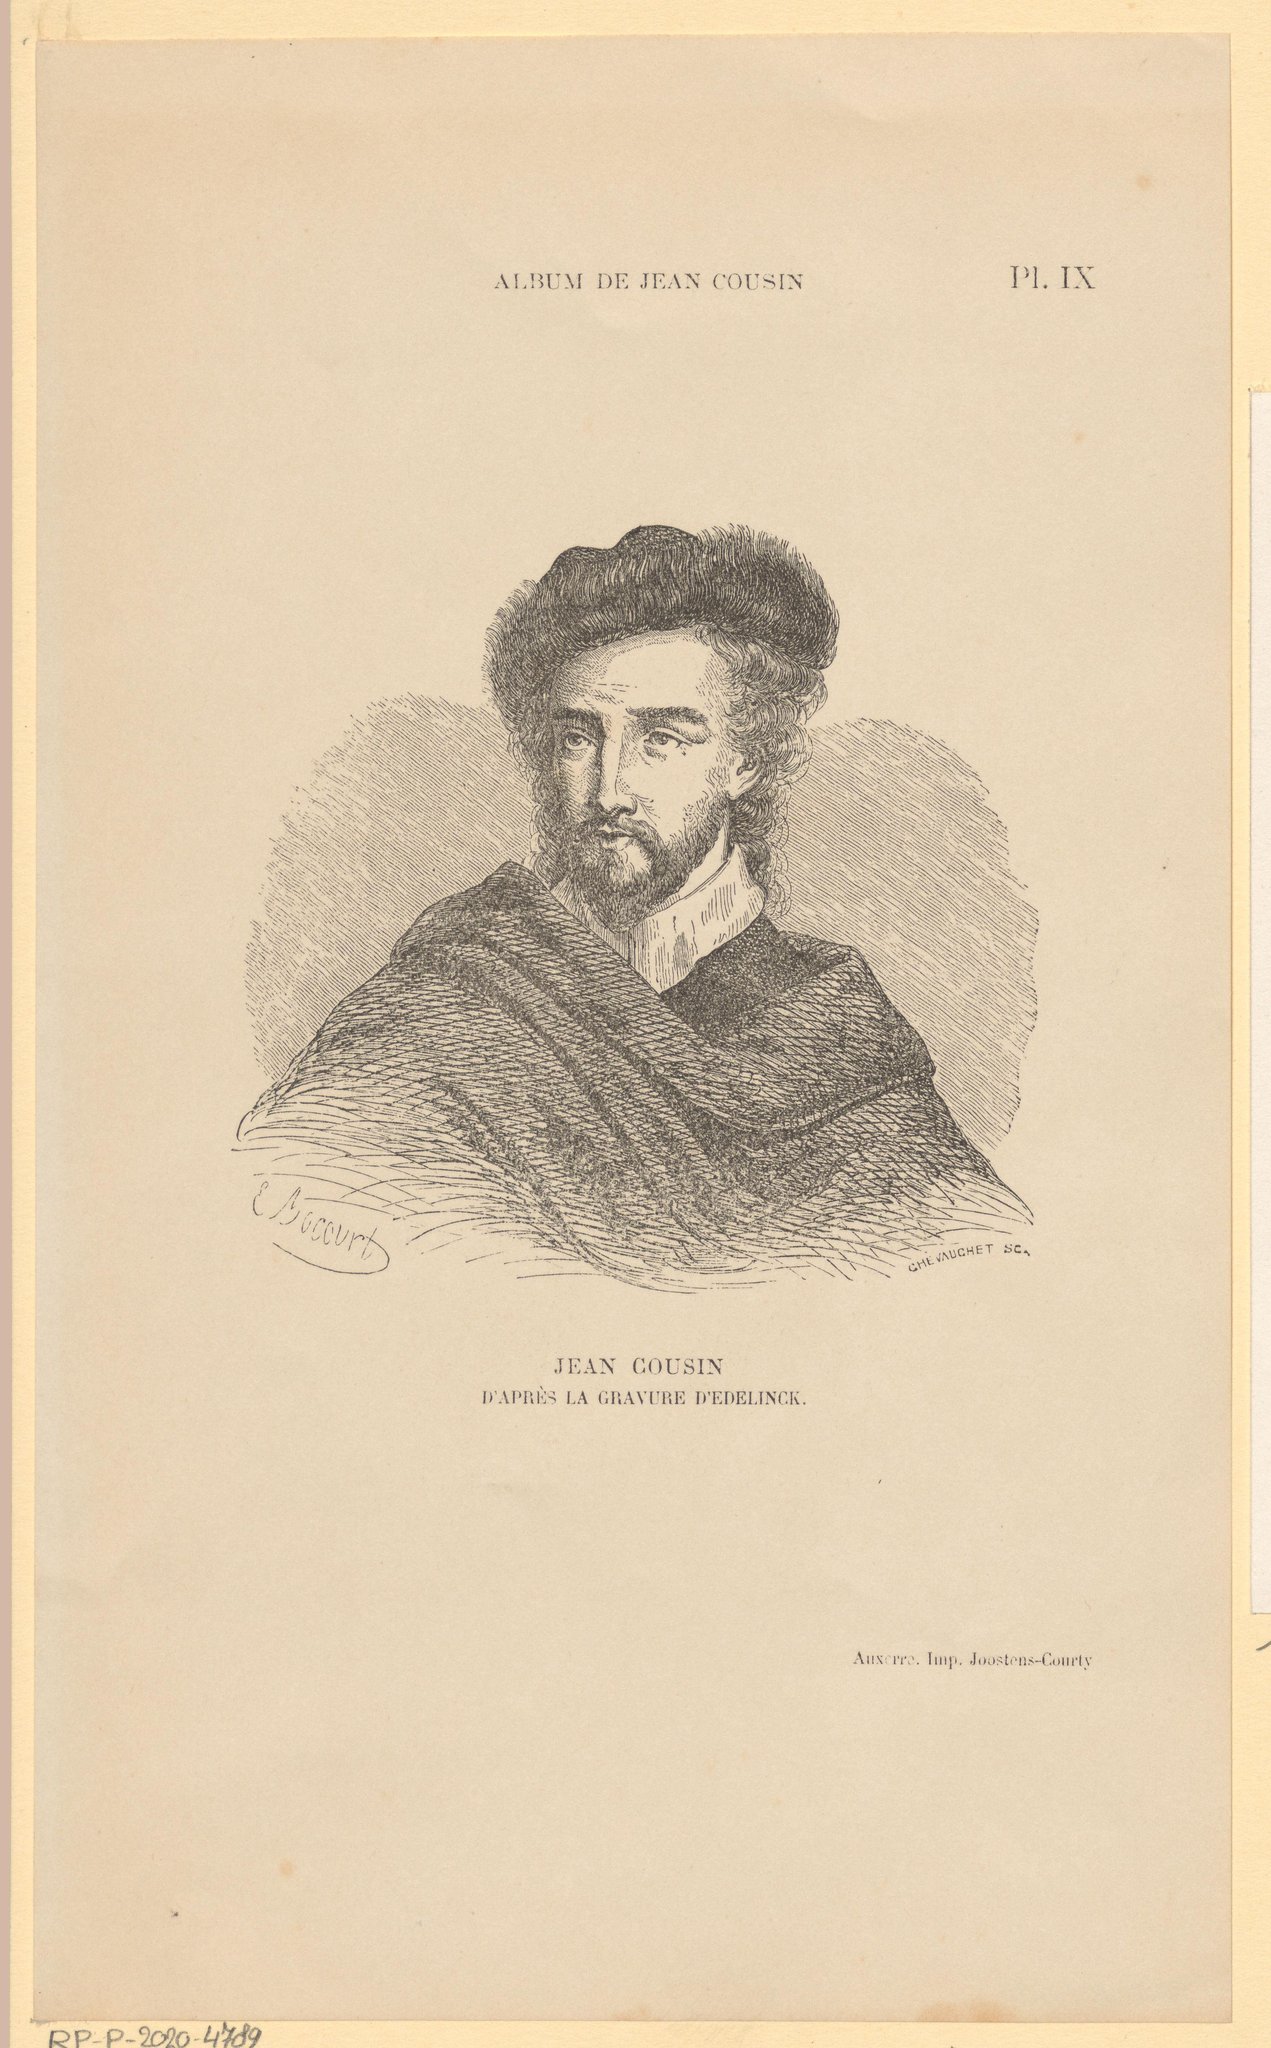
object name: print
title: Portret van Jean Cousin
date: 1800-1849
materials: paper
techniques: letterpress printing, engraving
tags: france, painter, print maker, jean cousin, portrait, self-portrait of painter